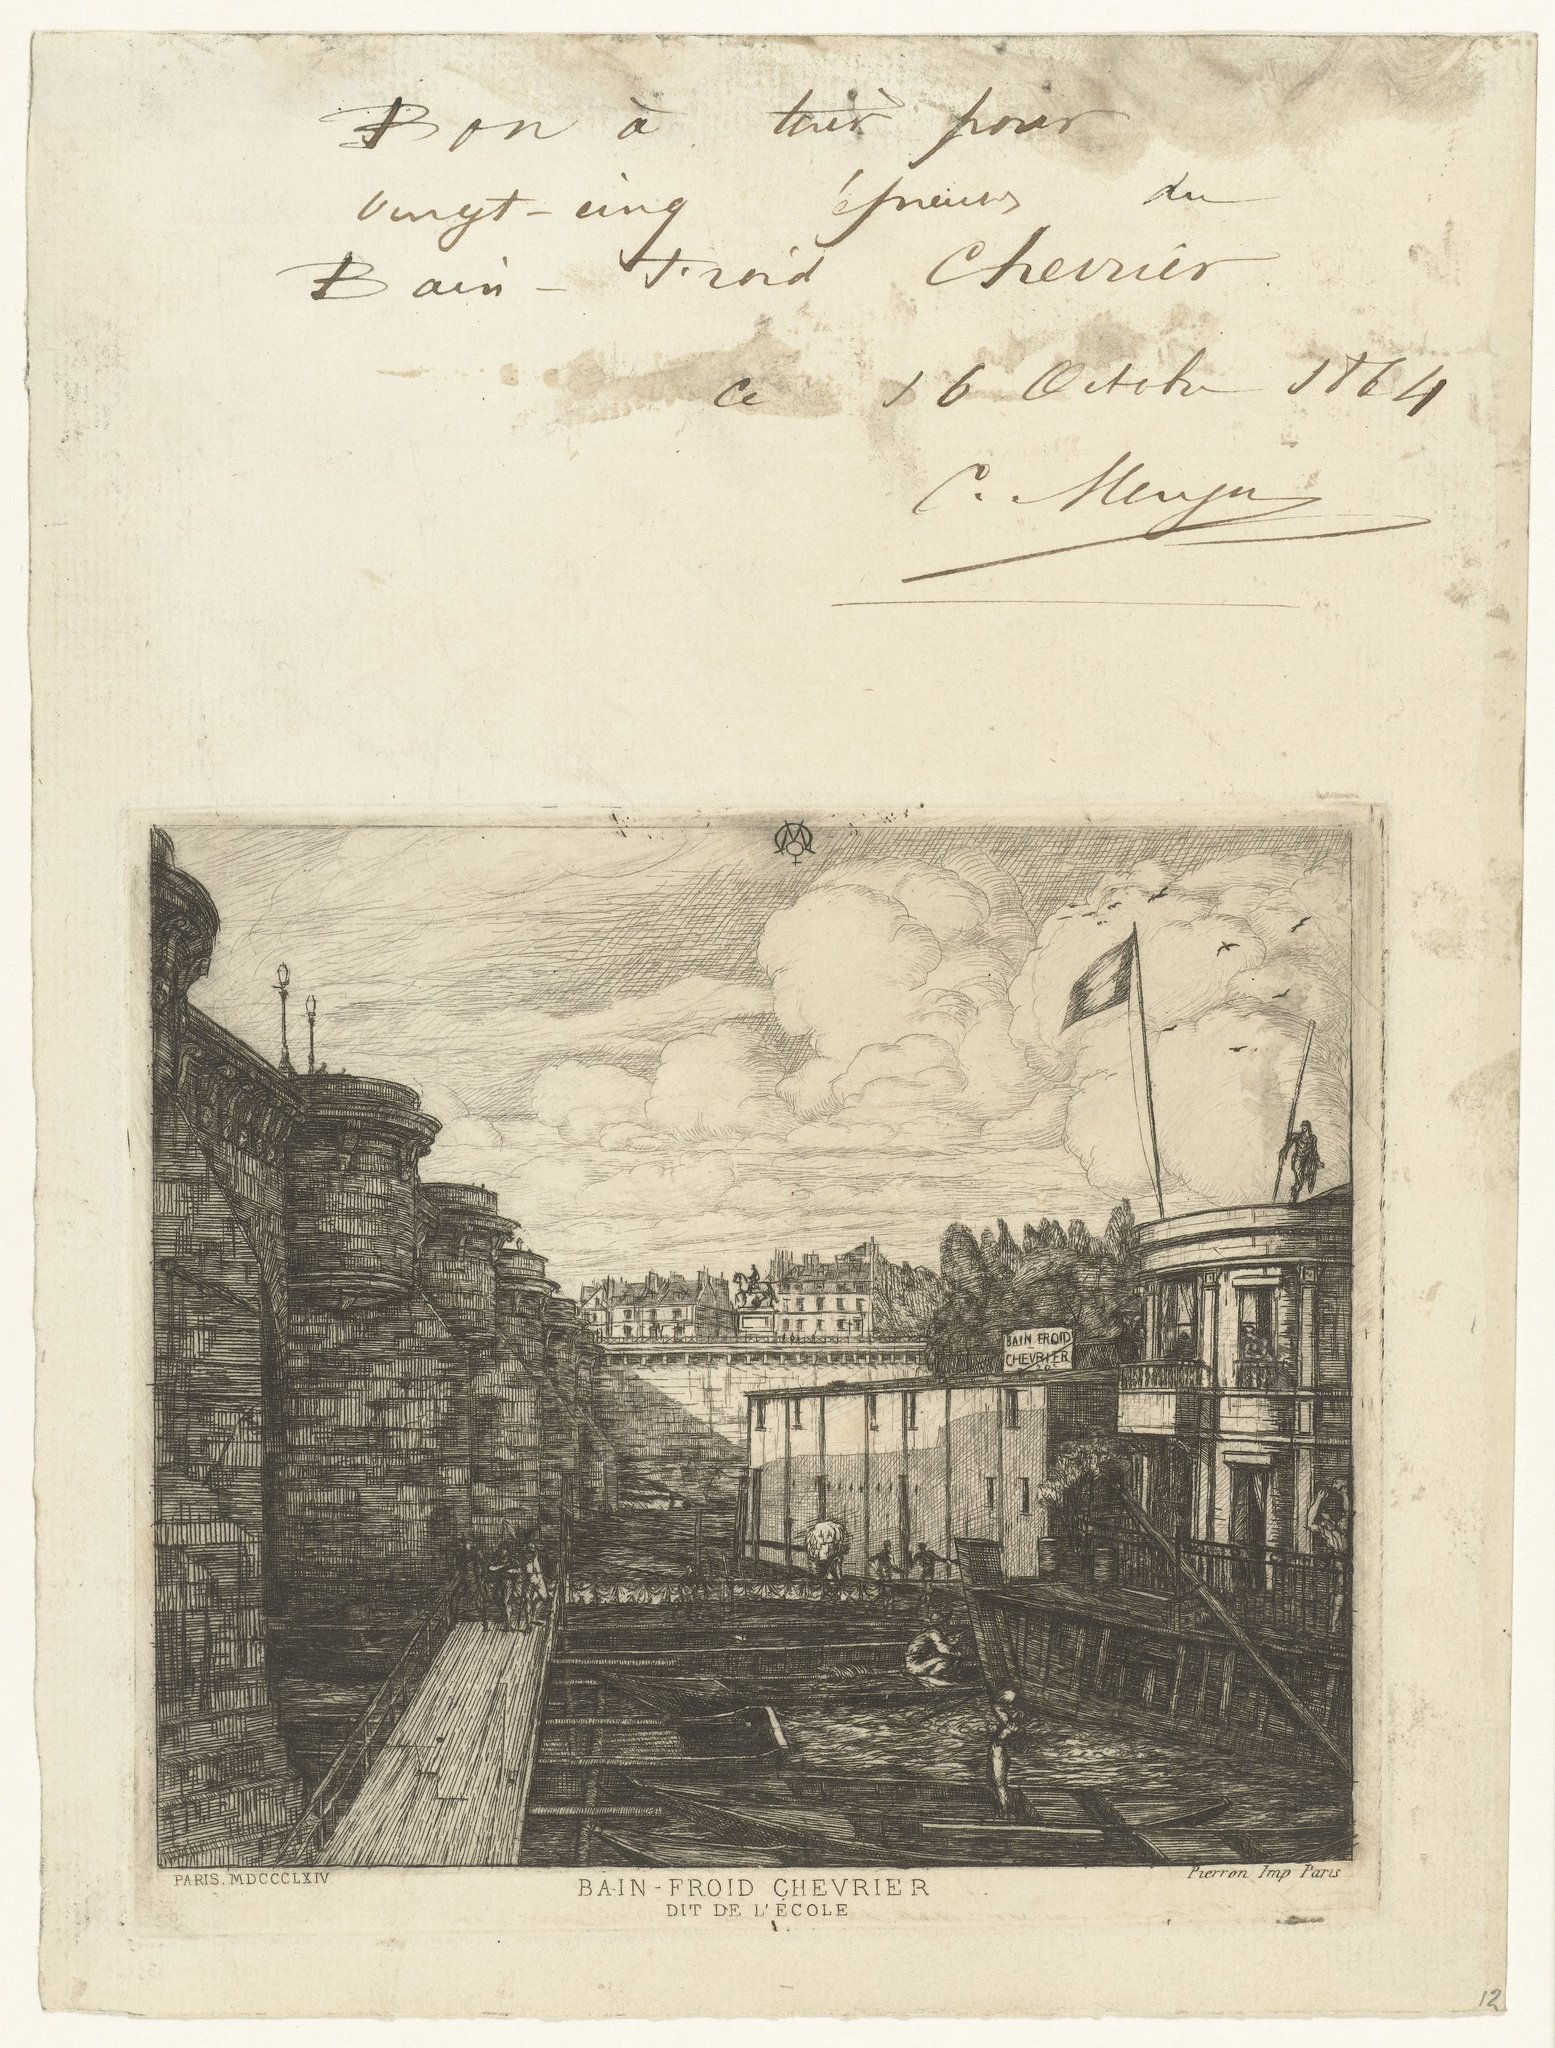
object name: print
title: Koud-water badhuis van Chevrier in Parijs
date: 1864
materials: paper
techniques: drypoint, etching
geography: paris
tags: public baths, paris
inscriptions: inscription: ‘Bon à tirer ... 16 Octobre 1864 C. Meryon’, collector's mark: Lugt 2760, collector's mark: Lugt 2228, collector's mark: Lugt 1336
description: Meryon kreeg van de Parijse fotograaf Jean-Louis-Henri Le Secq de opdracht om deze karakteristieke plek in Parijs in prent te brengen. Deze prent is in eigendom geweest van de fotograaf, zie het verzamelaarmerk. Meryon stemde ermee in dat Le Secq de koperplaat kreeg om een oplage te drukken. Hij stelde wel de voorwaarde dat de plaat vernietigd zou worden maar dit is vreemd genoeg nooit gebeurd. Uit briefwisselingen is bekend dat hij sommige details met behulp van een vergrootglas uitwerkte (De Groot 1991, p. 86).